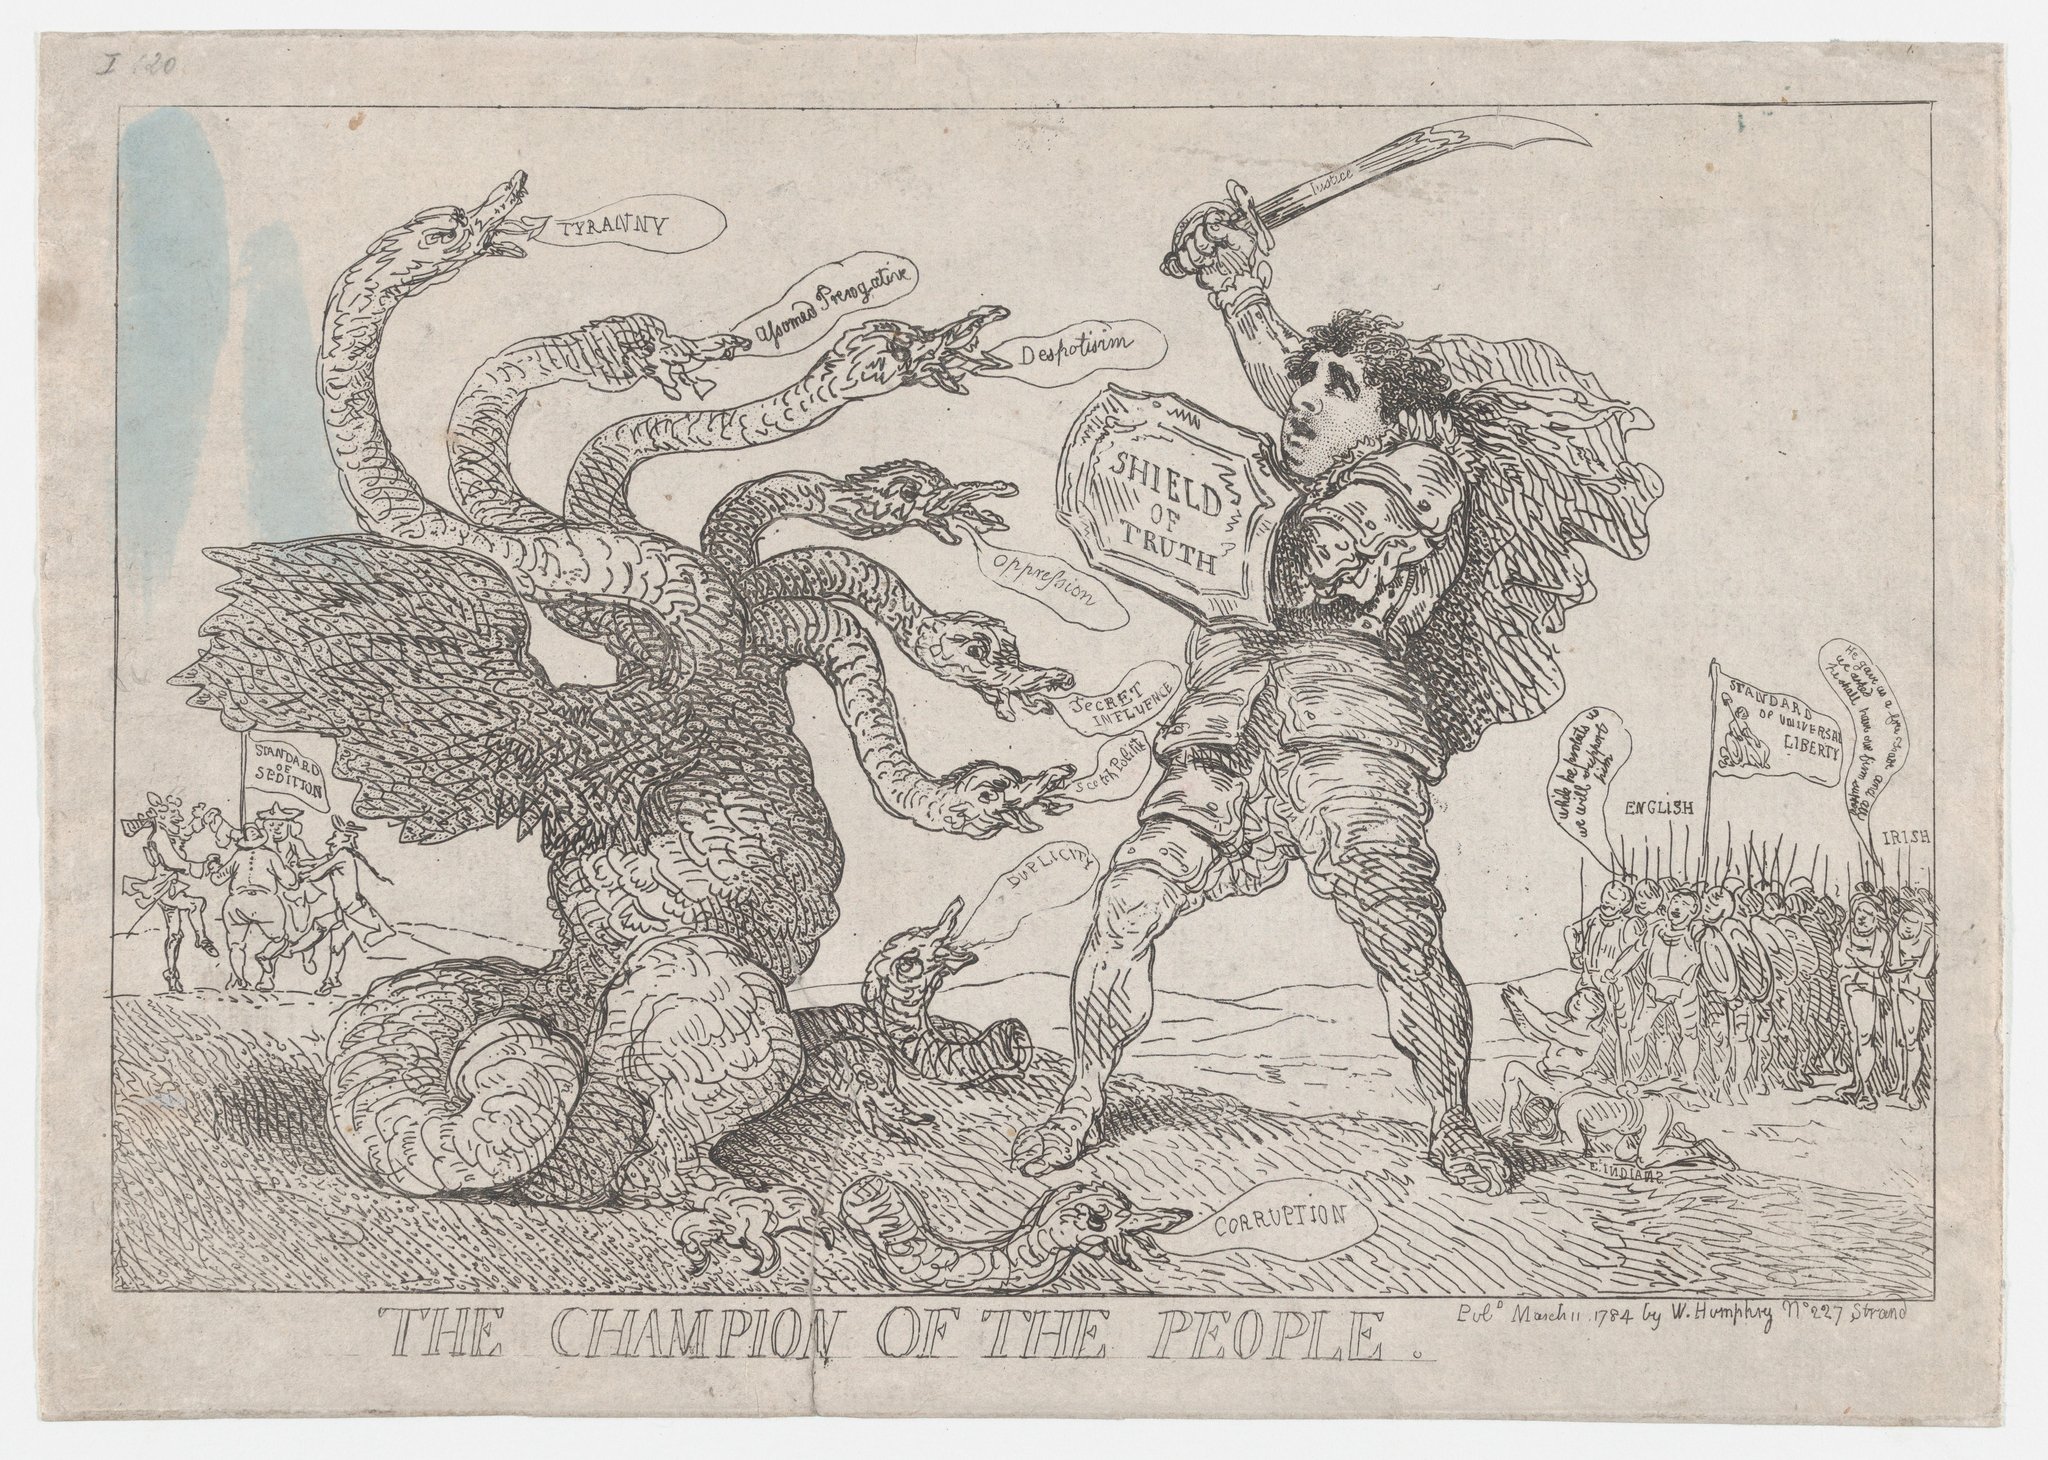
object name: print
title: The Champion of the People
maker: thomas rowlandson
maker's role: artist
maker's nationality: british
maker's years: 1757-1827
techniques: etching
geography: london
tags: satire,men